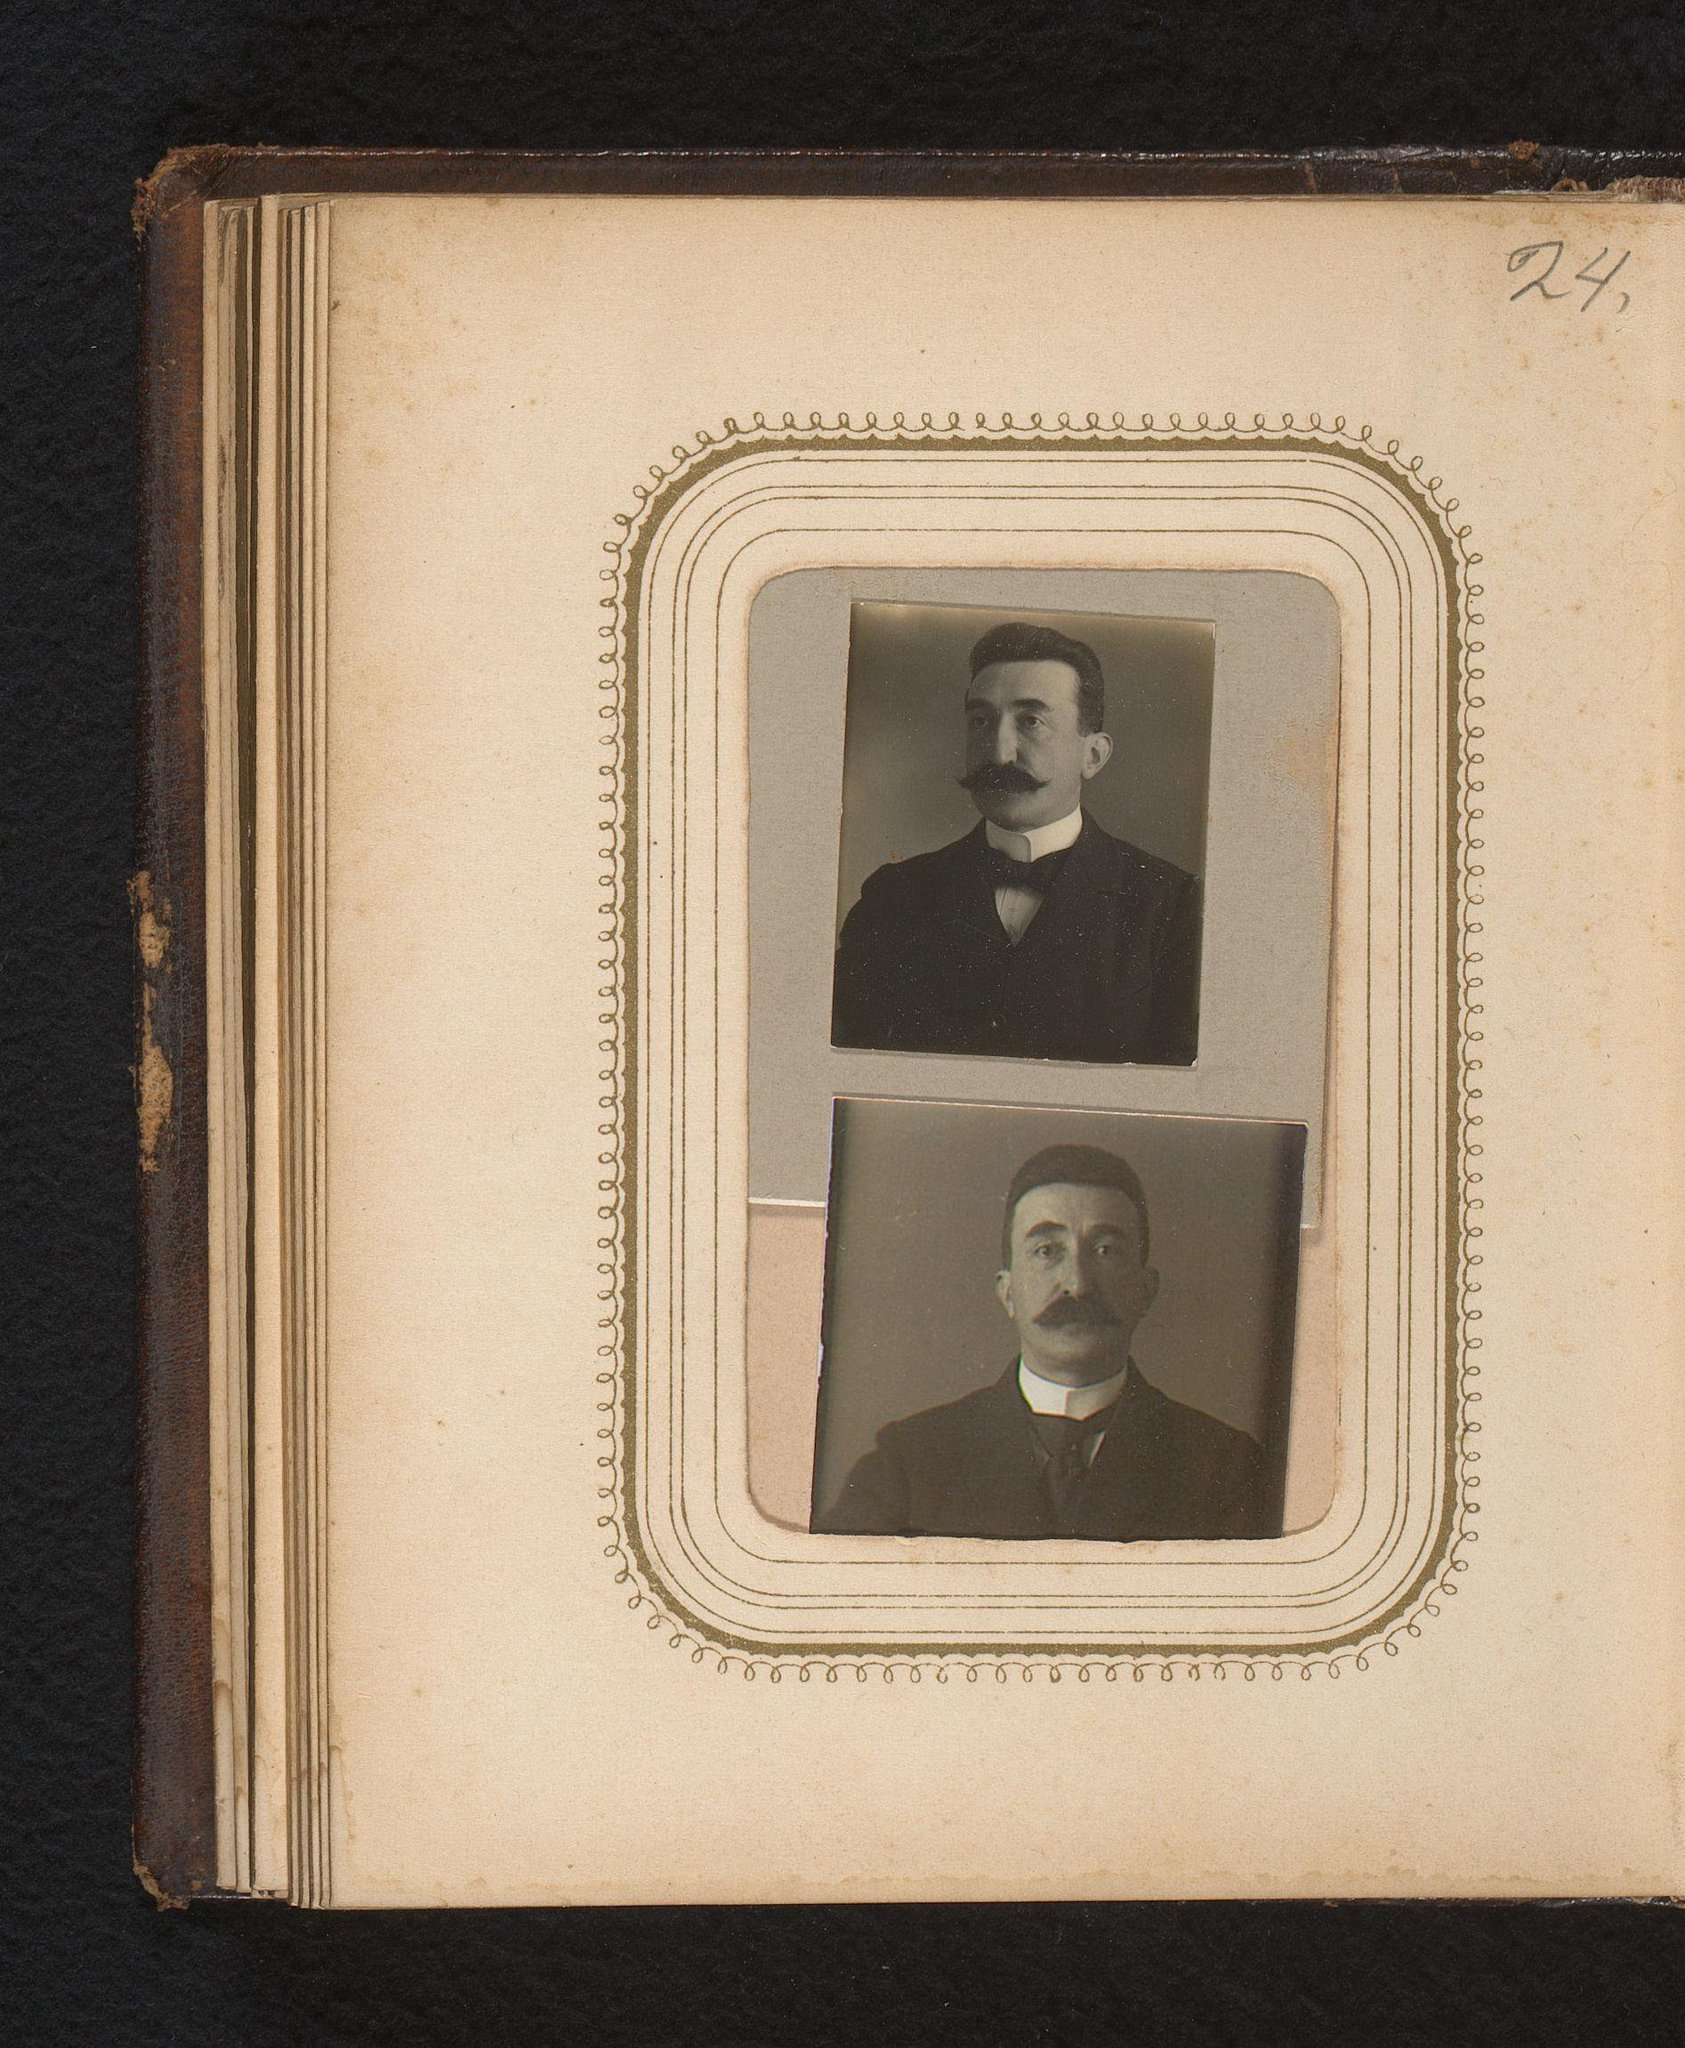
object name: snapshot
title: Twee portretten van François Buys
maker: Anonymous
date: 1910-1920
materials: paper, cardboard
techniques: gelatin silver print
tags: françois buys, historical persons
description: Deze foto's maken deel uit van een album.